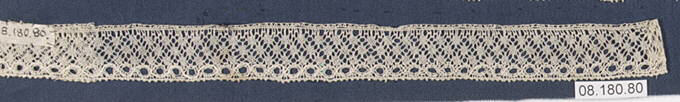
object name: fragment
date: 1801-1900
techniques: lace